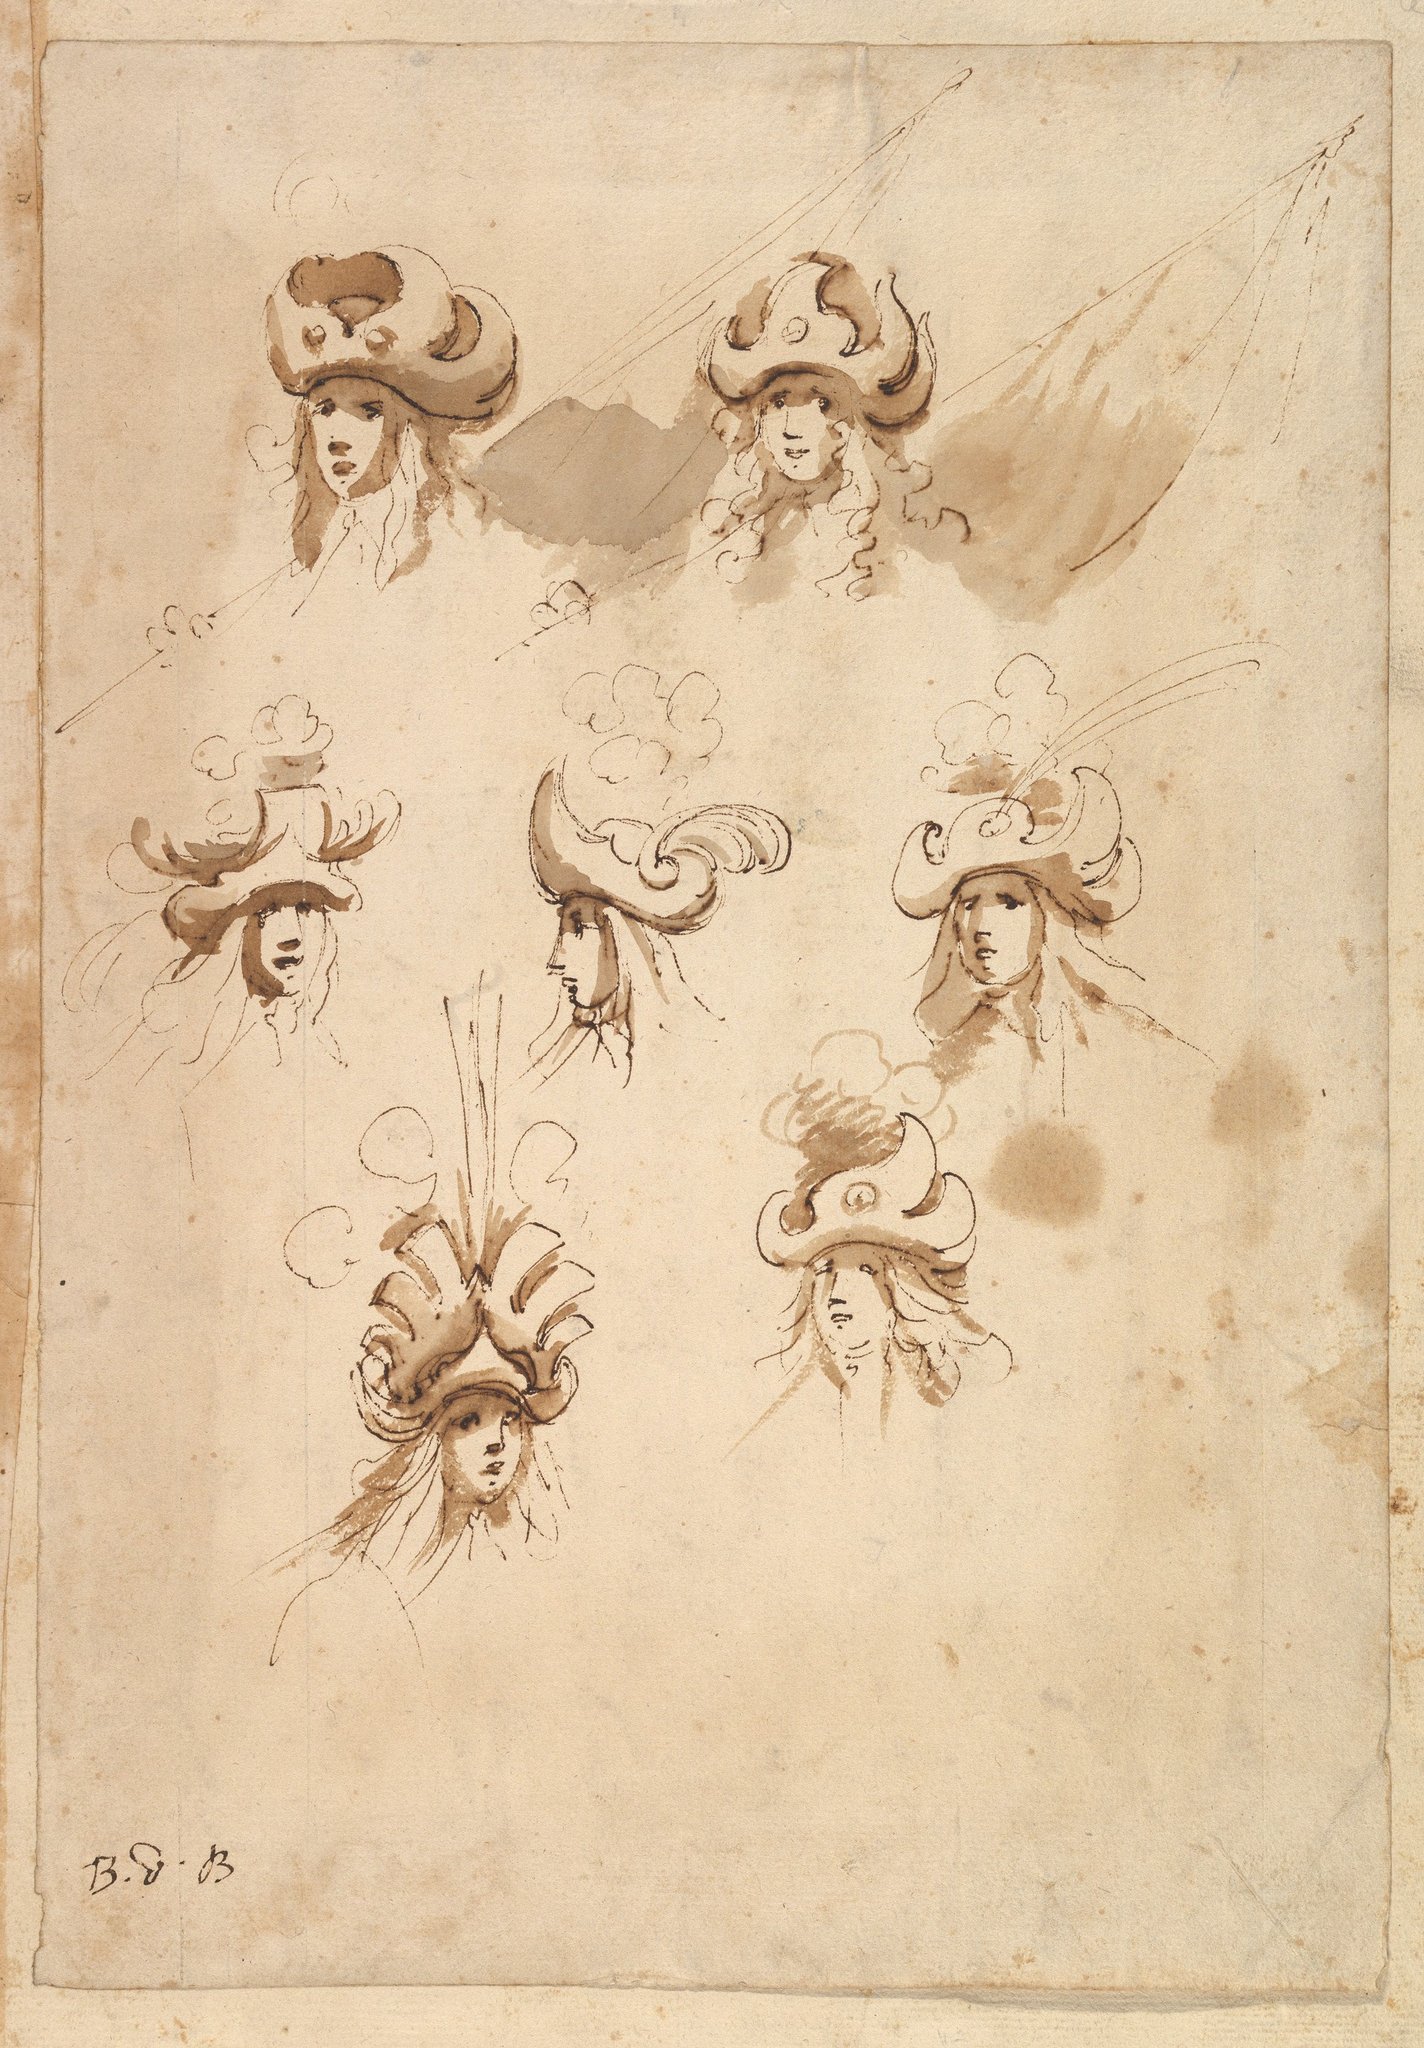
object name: collection ornament architecture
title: Seven Designs for Hats.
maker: baccio del bianco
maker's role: artist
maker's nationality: italian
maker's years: 1604-1656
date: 1620-1656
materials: ink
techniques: wash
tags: hats,faces,men